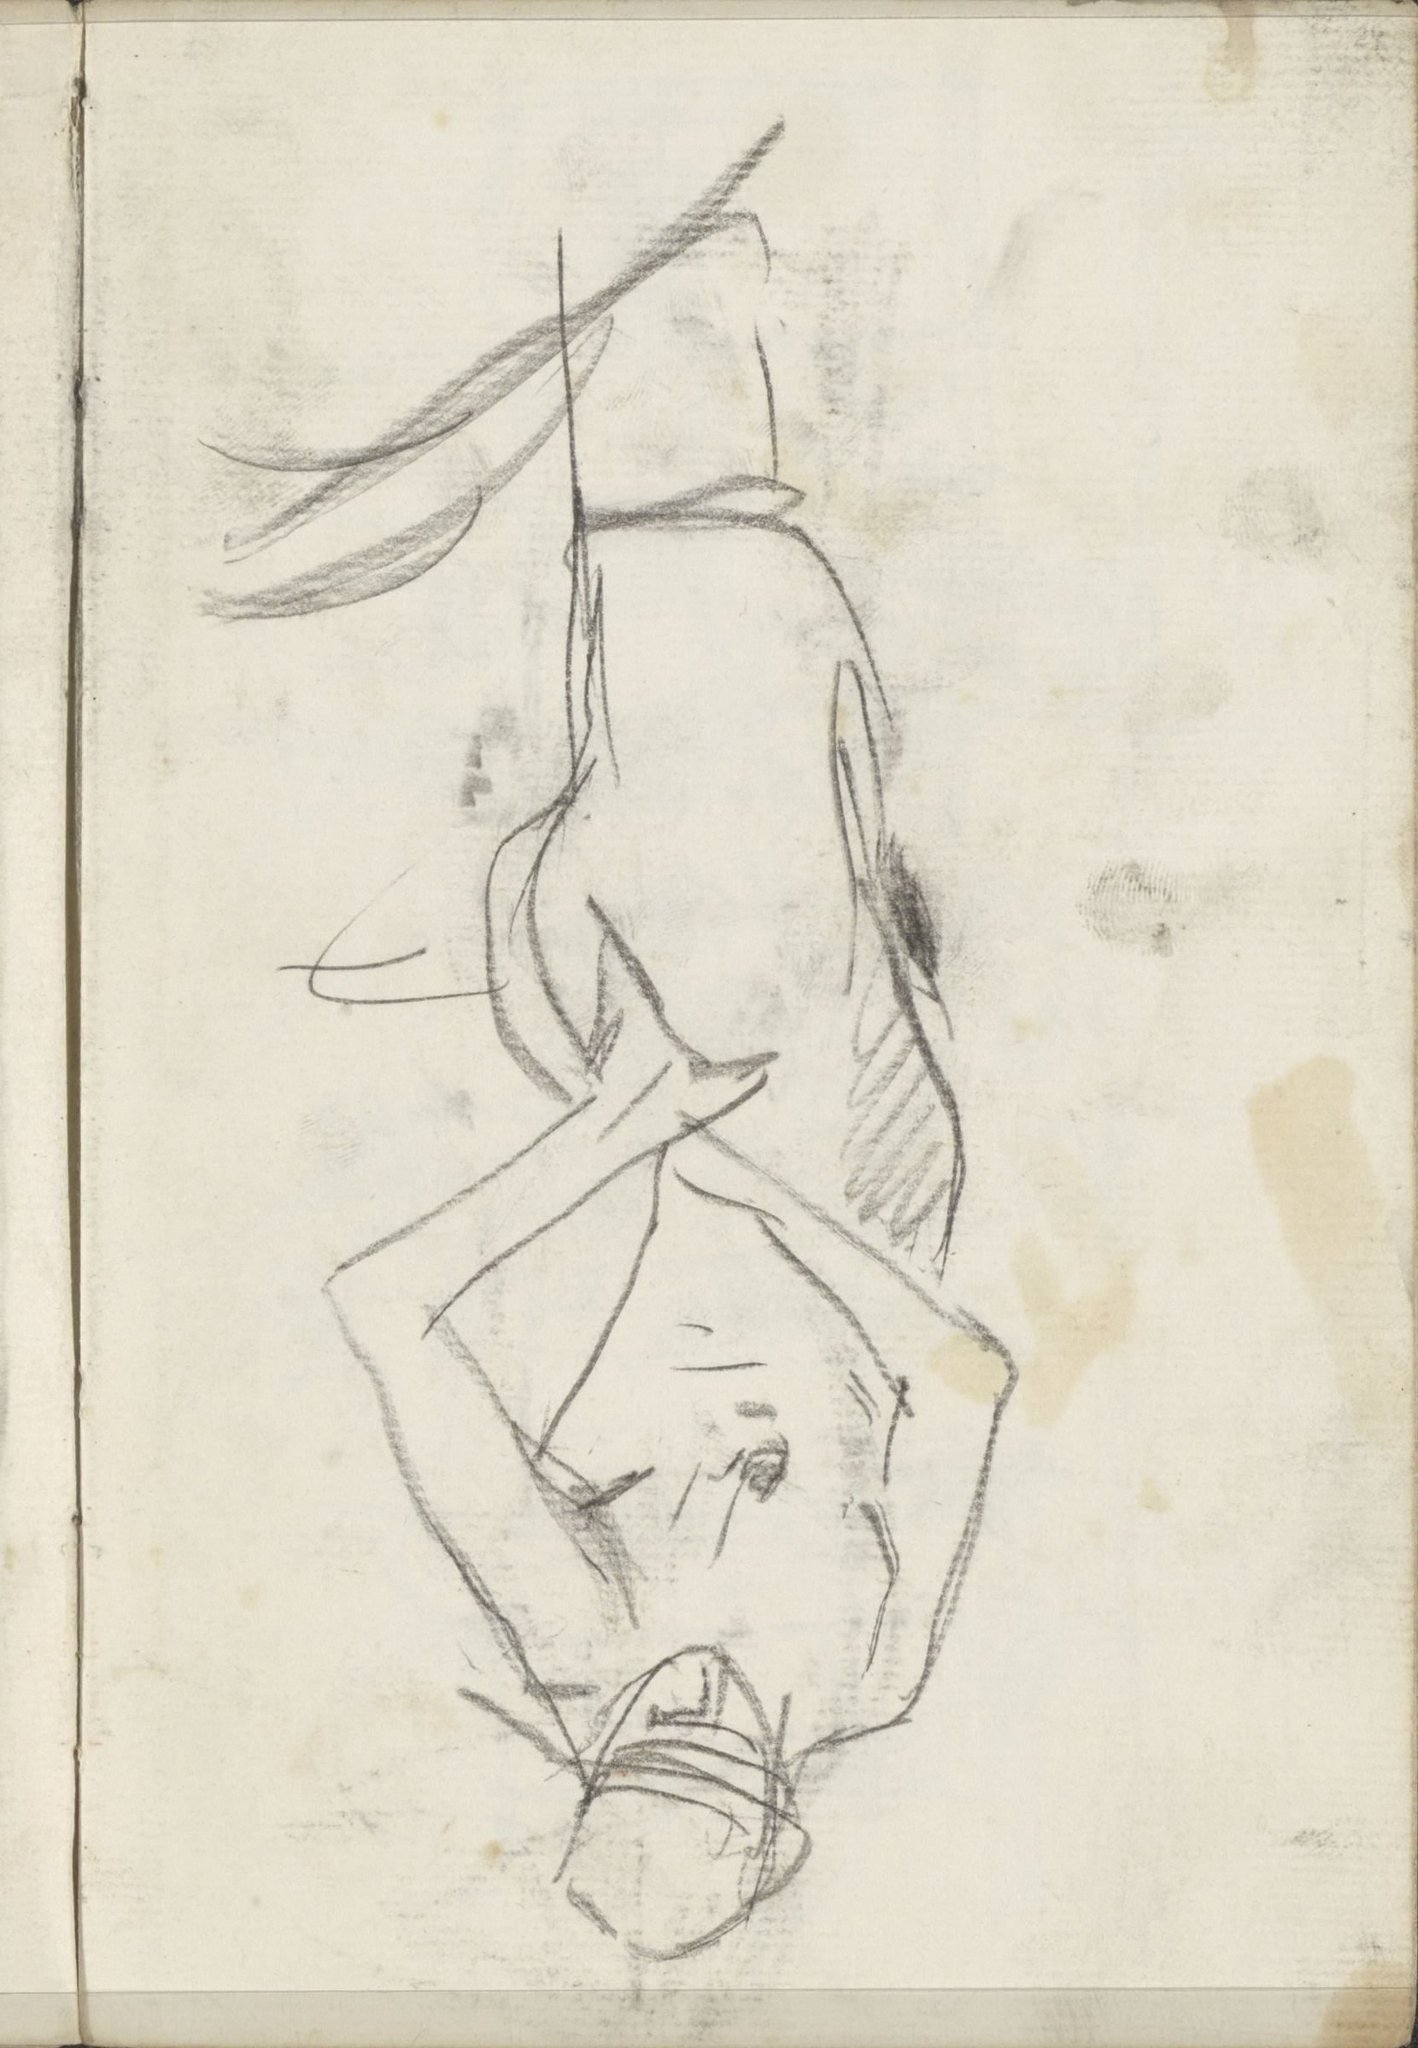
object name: sketchbook leaf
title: Staand vrouwelijk naakt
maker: george hendrik breitner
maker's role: draughtsman, painter, print maker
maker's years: 1857-1923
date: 1886-1898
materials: chalk, paper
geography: amsterdam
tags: the (nude) human figure; 'corpo humano' (ripa) - aa - female human figure (+ standing)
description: Pagina 24 uit een schetsboek met 21 bladen.